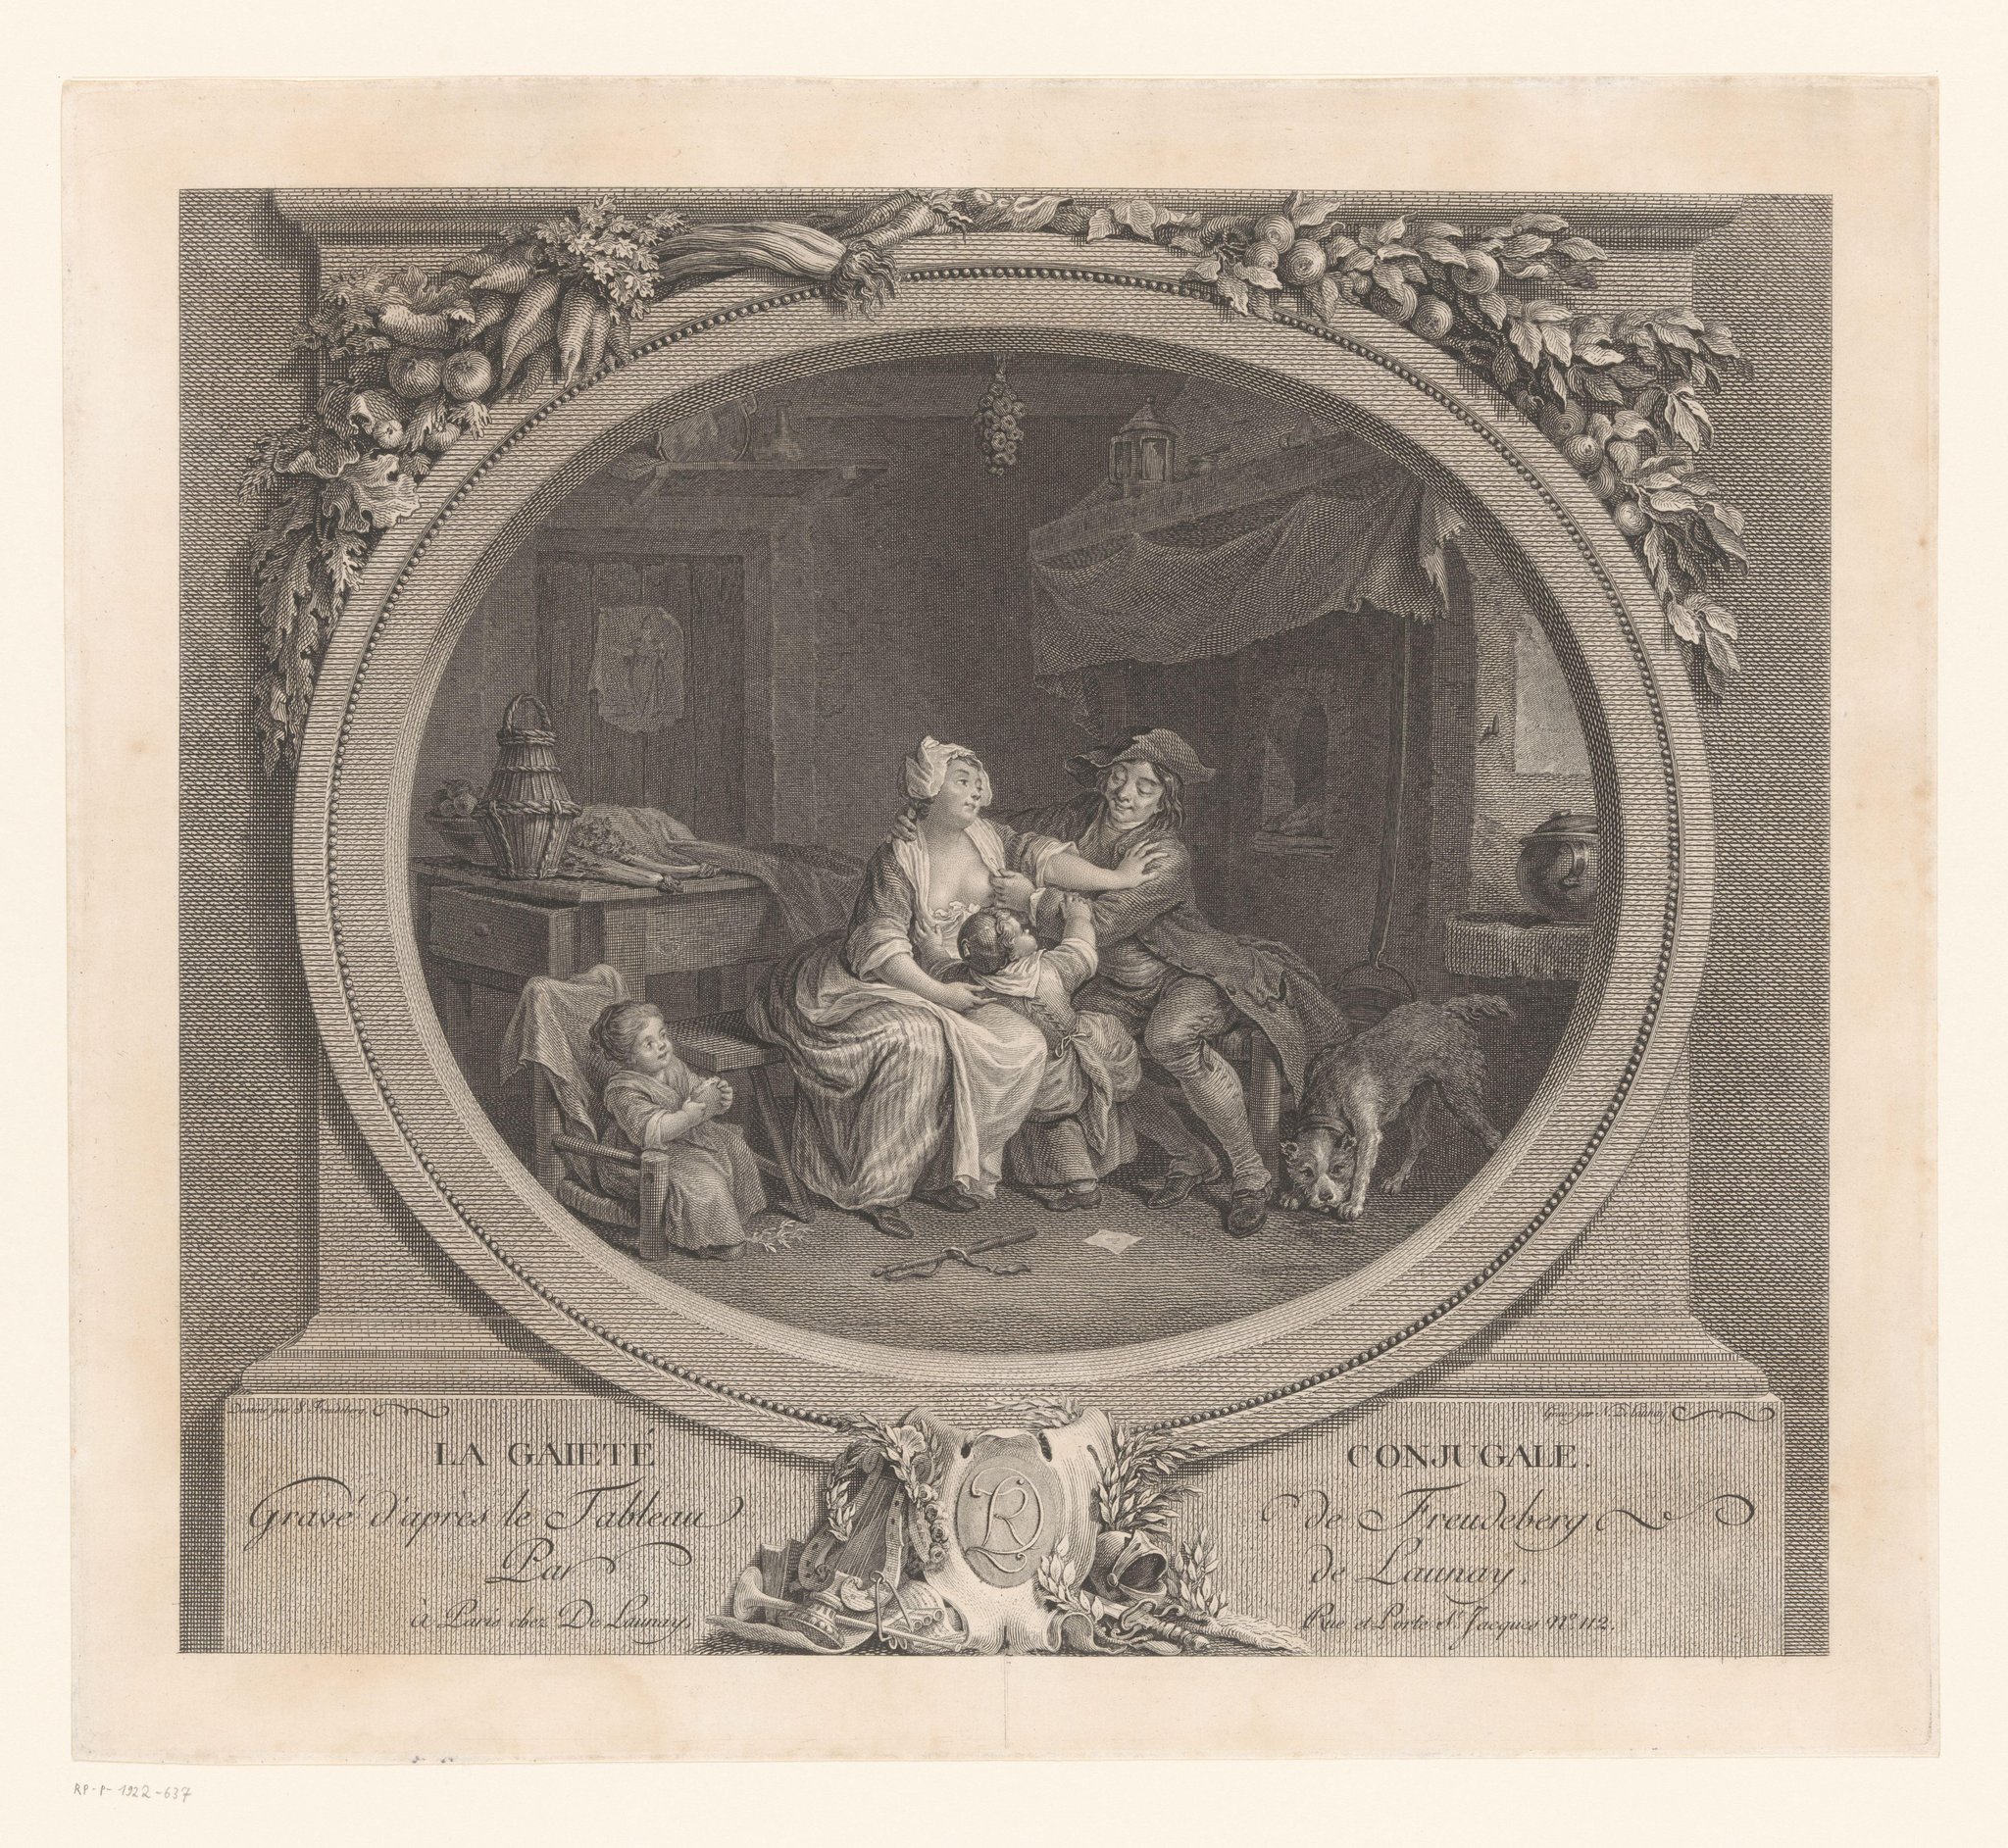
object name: print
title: La gaieté conjugale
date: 1783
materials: paper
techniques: engraving, etching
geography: france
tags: parents with their children, courting, hand uncovering the chest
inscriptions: collector's mark: Lugt 2228